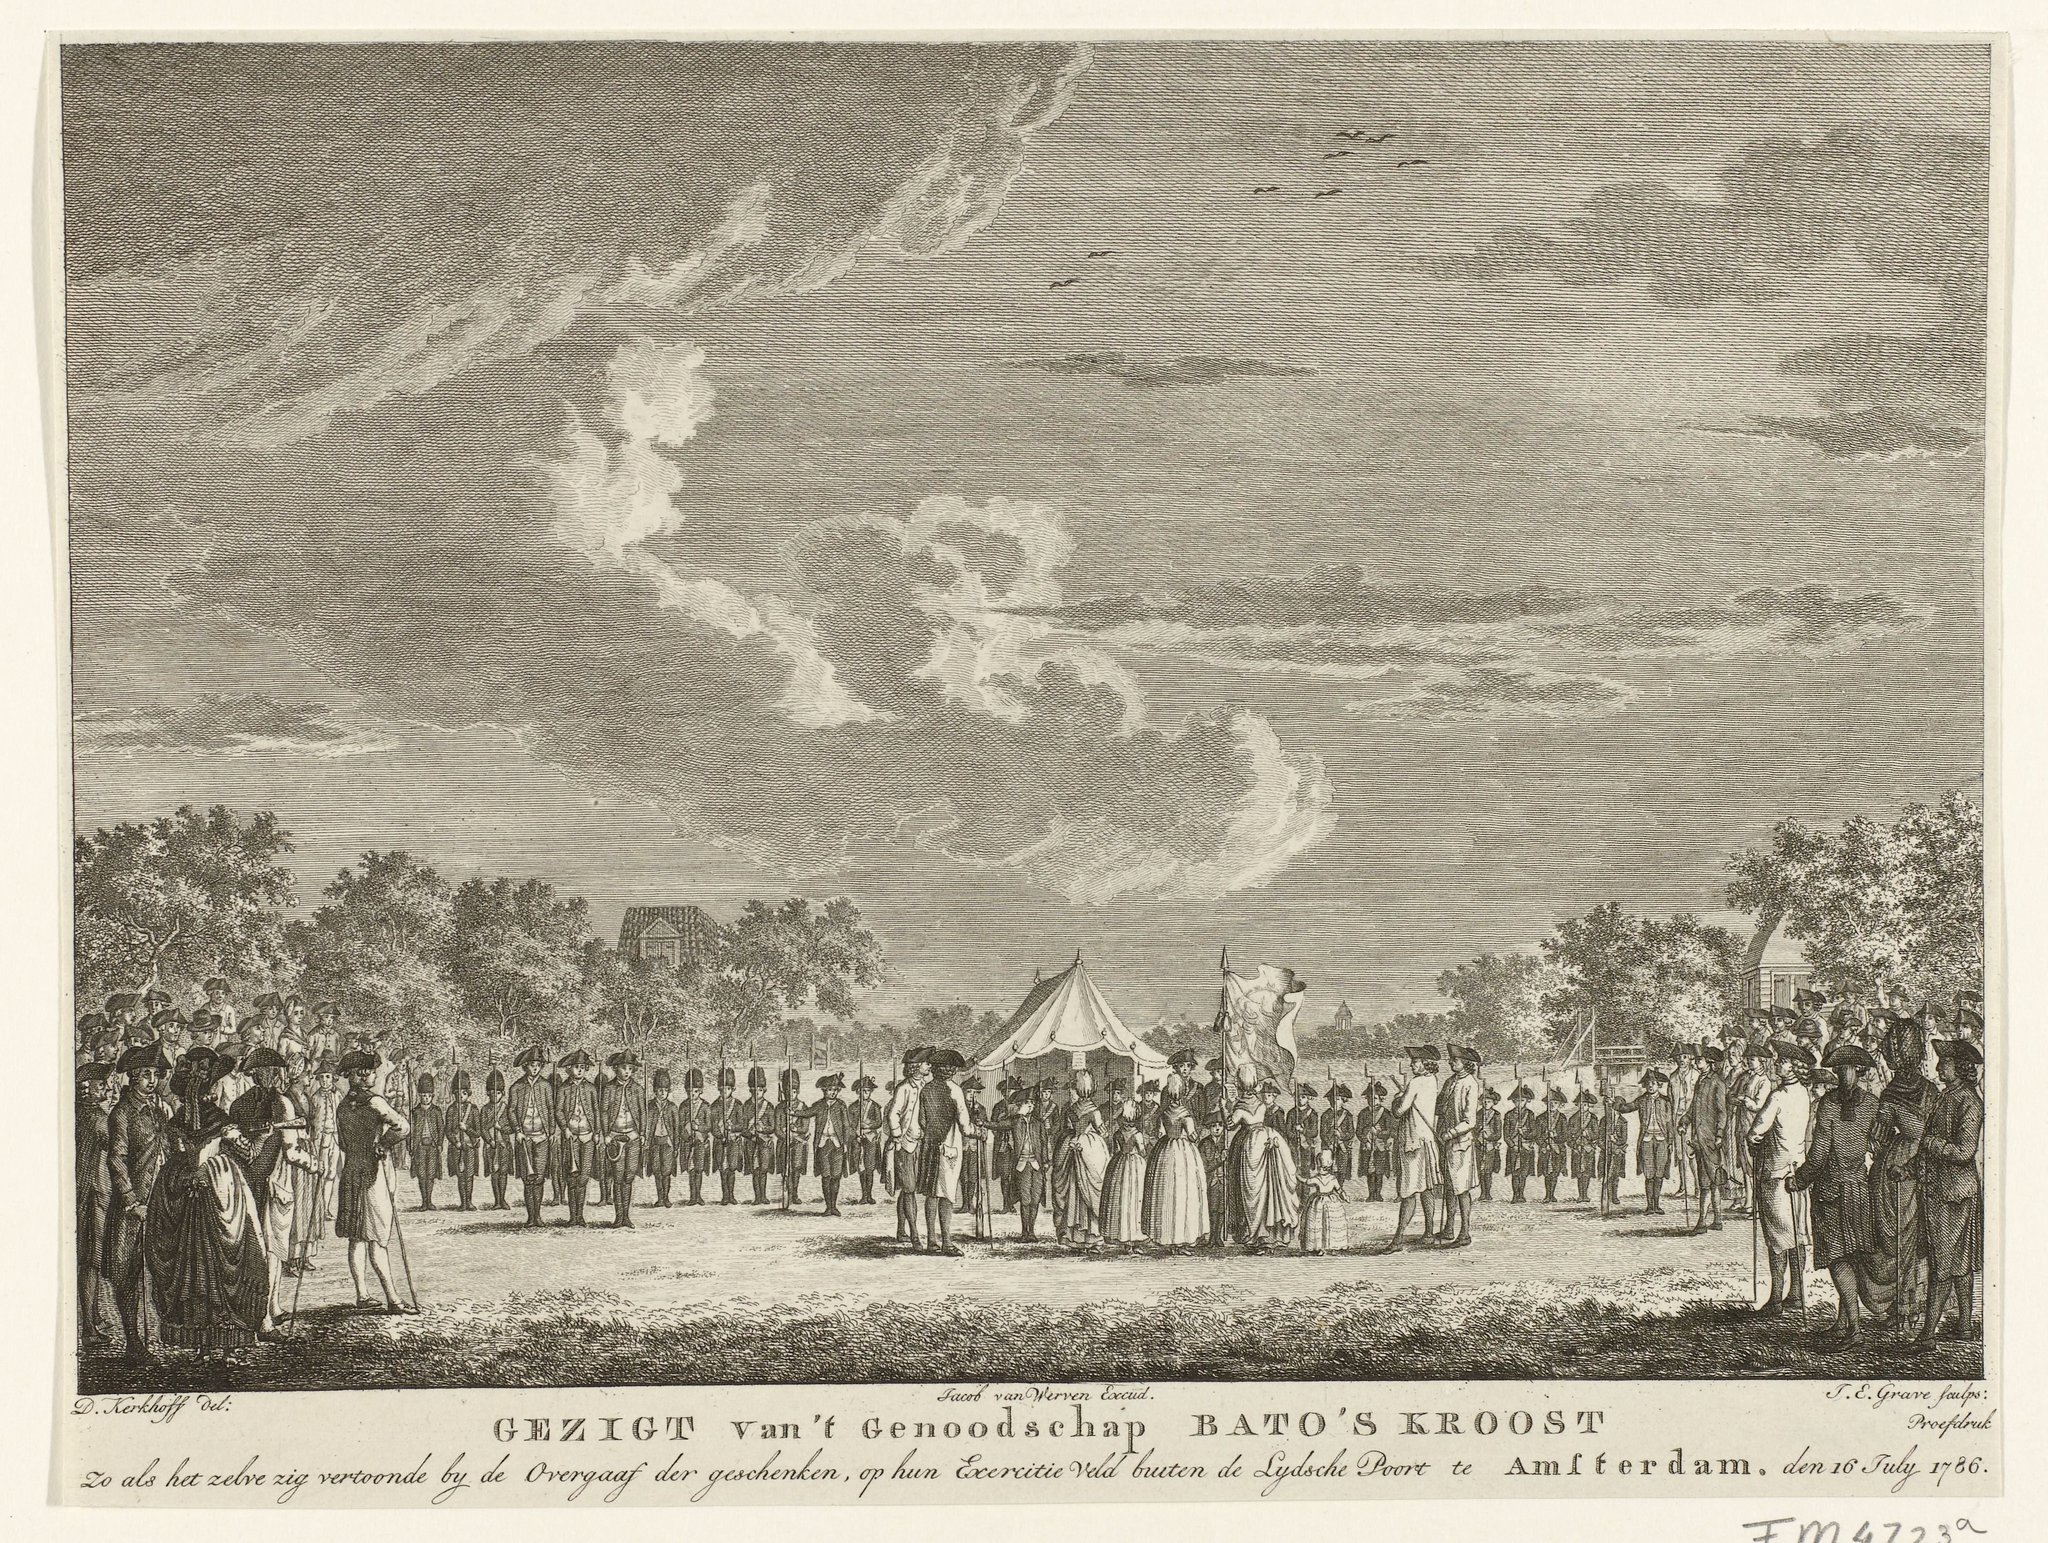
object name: print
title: Gezigt van 't Genoodschap Bato's Kroost / Zo als het zelve zig vertoonde by de Overgaaf der geschenken, op hun Exercitie Veld buiten de Lydsche Poort te Amsterdam. den 16 July 1786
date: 1786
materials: paper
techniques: engraving, etching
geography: northern netherlands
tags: military demonstrations (+ citizen soldiery, civil guard, citizen militia), amsterdam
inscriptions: collector's mark: Lugt 2228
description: Plechtige overdracht van de geschenken van de vaandel, trom en geweren aan het Amsterdamse exercitiegenootschap Bato's Kroost, op het exercitieterrein buiten de Leidsepoort te Amsterdam, 16 juli 1786. De geschenken aangereikt door enkele dames, donatrices, aan de vaandrigs van de schutterij. Op de achtergrond de opgestelde schutters.